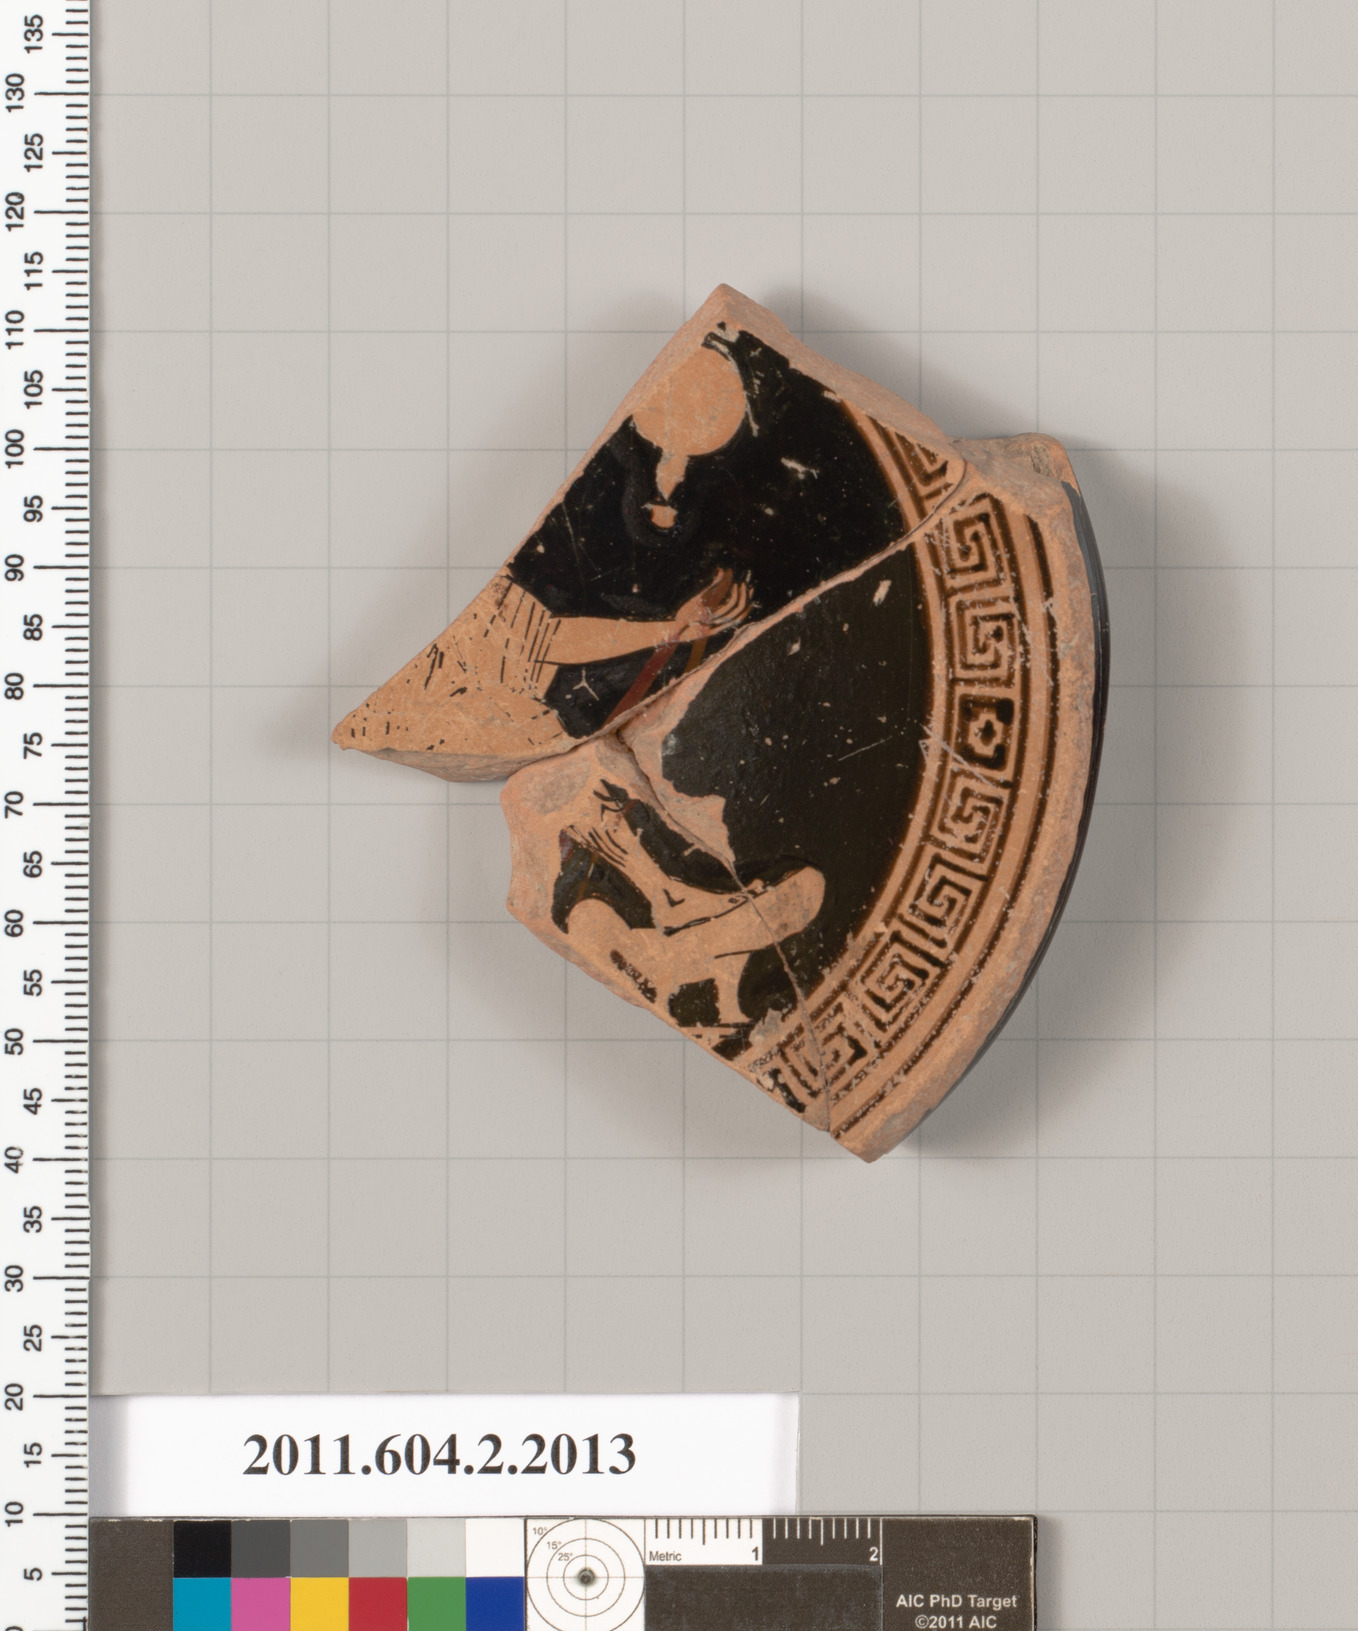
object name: plate fragment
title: Terracotta fragment of a plate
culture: greek, attic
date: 480-470 BCE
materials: terracotta